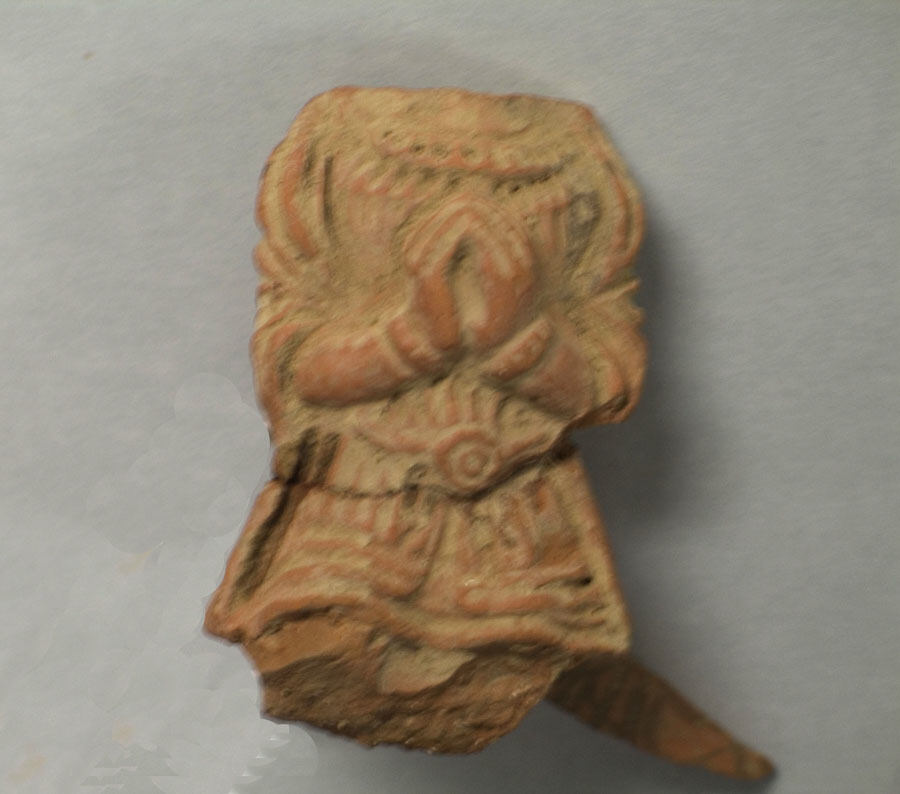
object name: fragment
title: Lug from a Vessel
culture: pakistani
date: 301-500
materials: terracotta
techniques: painting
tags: human figures,gandhara